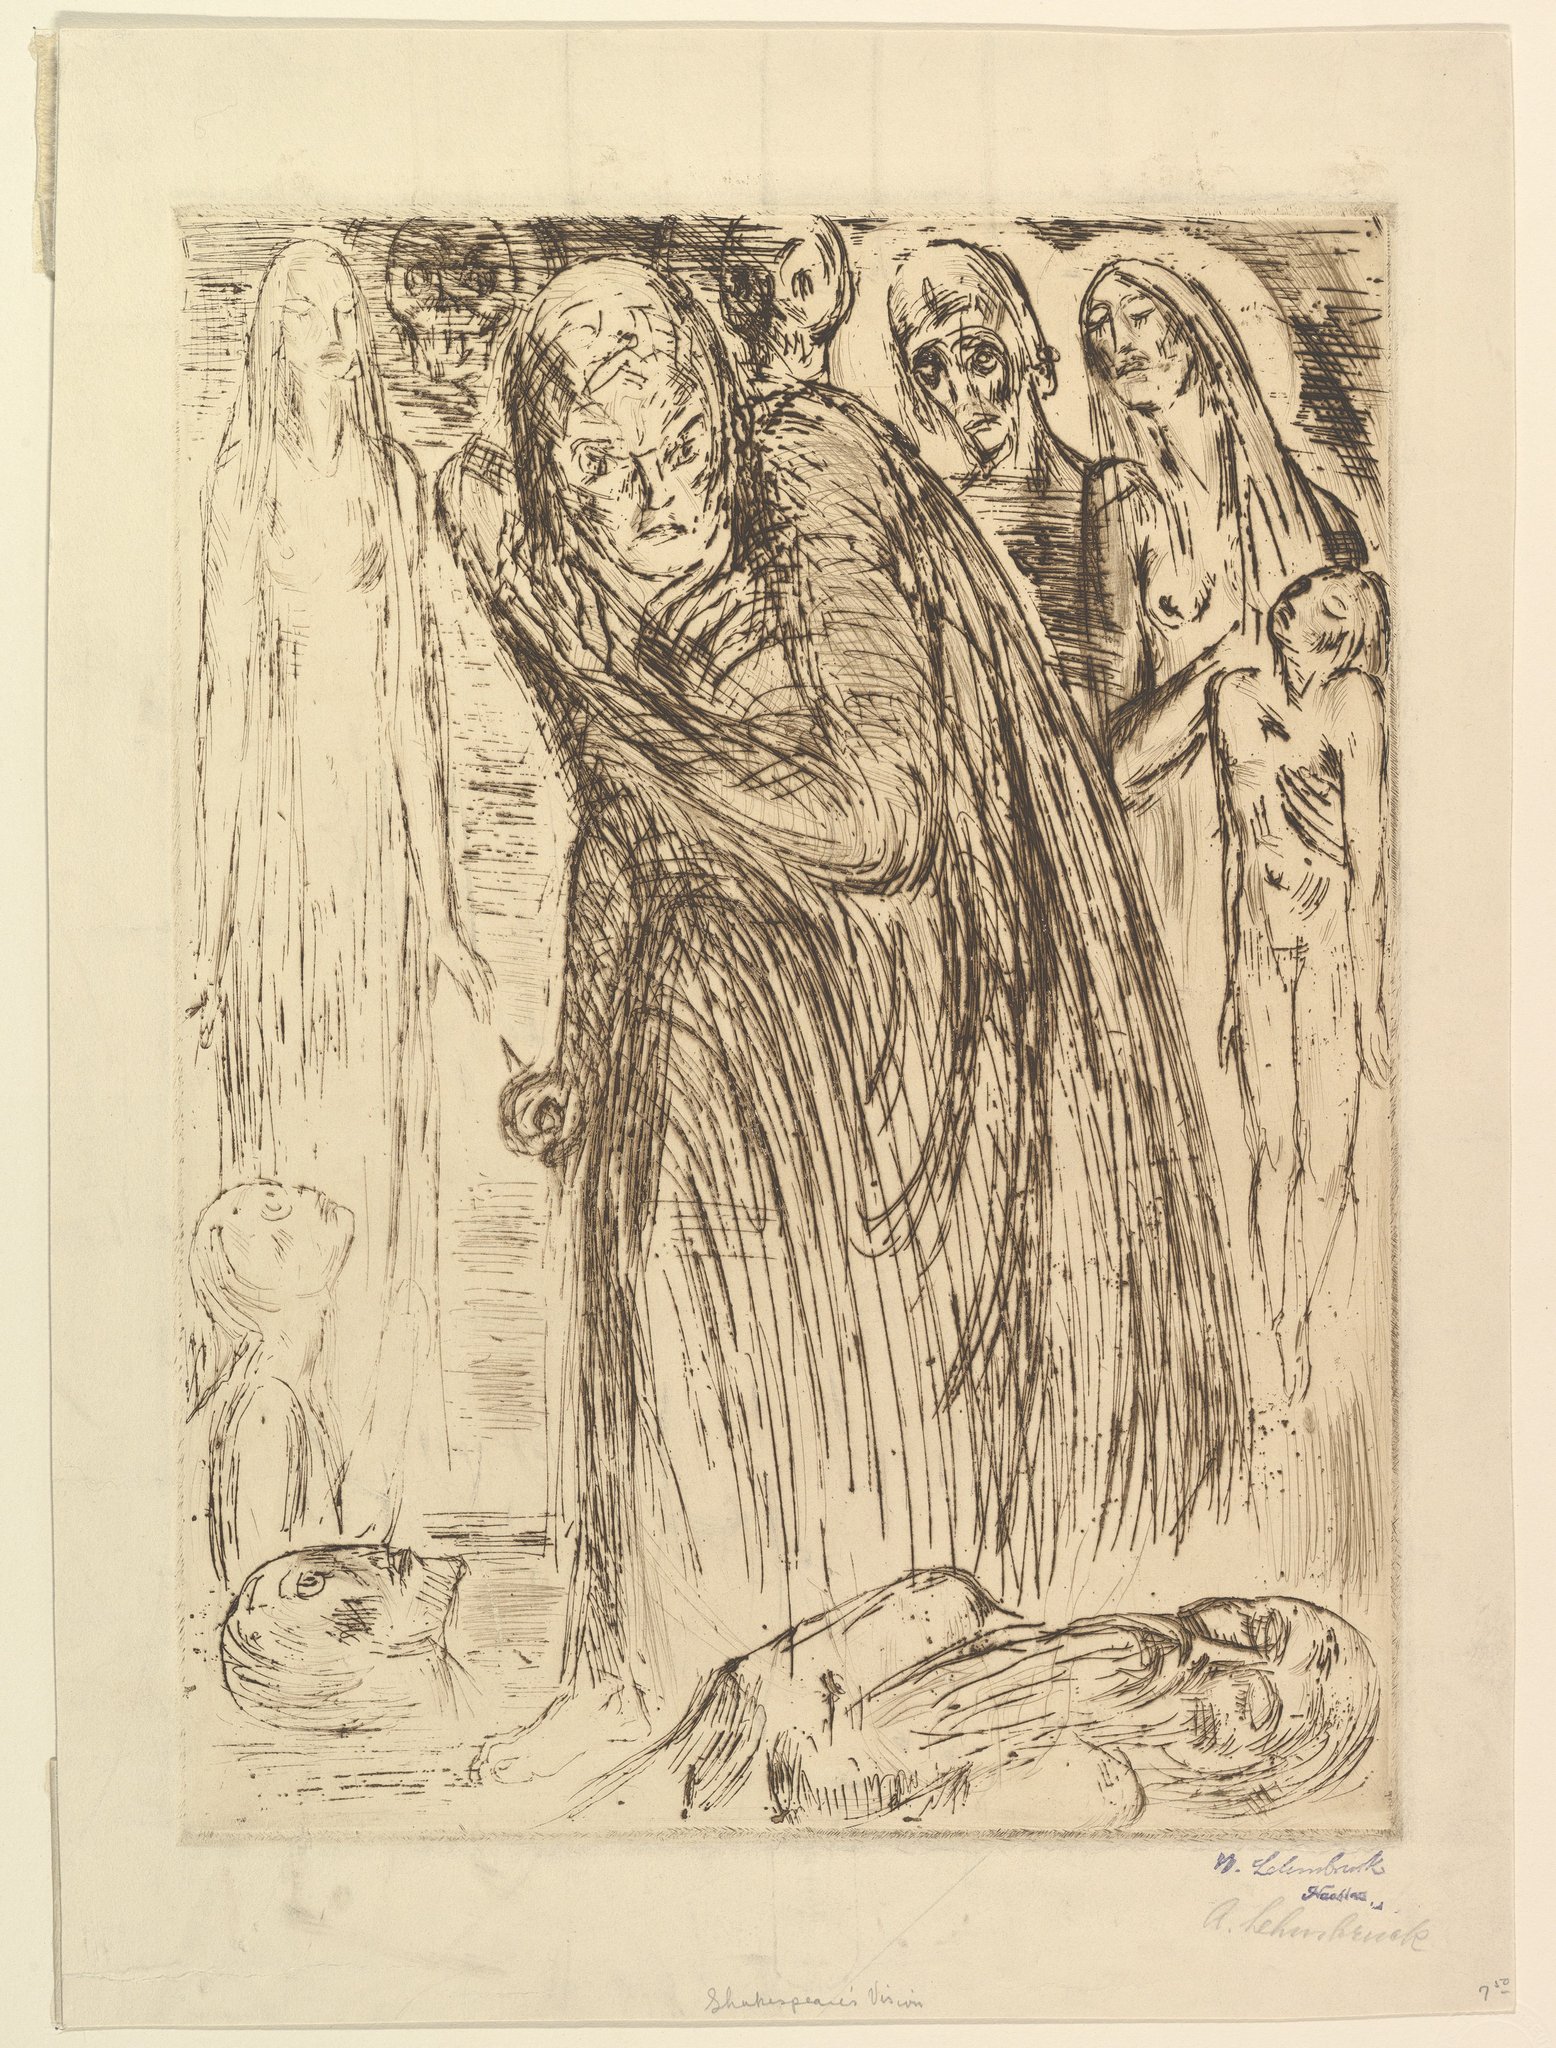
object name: print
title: Macbeth IV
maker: wilhelm lehmbruck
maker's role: artist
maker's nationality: german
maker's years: 1881-1919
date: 1918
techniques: drypoint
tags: shakespeare,men,macbeth